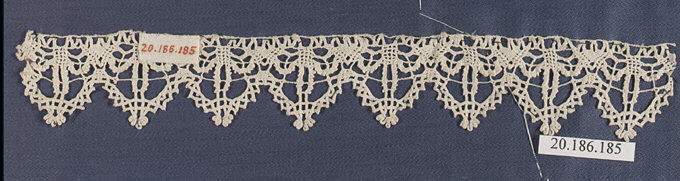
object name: edging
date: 1501-1600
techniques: lace